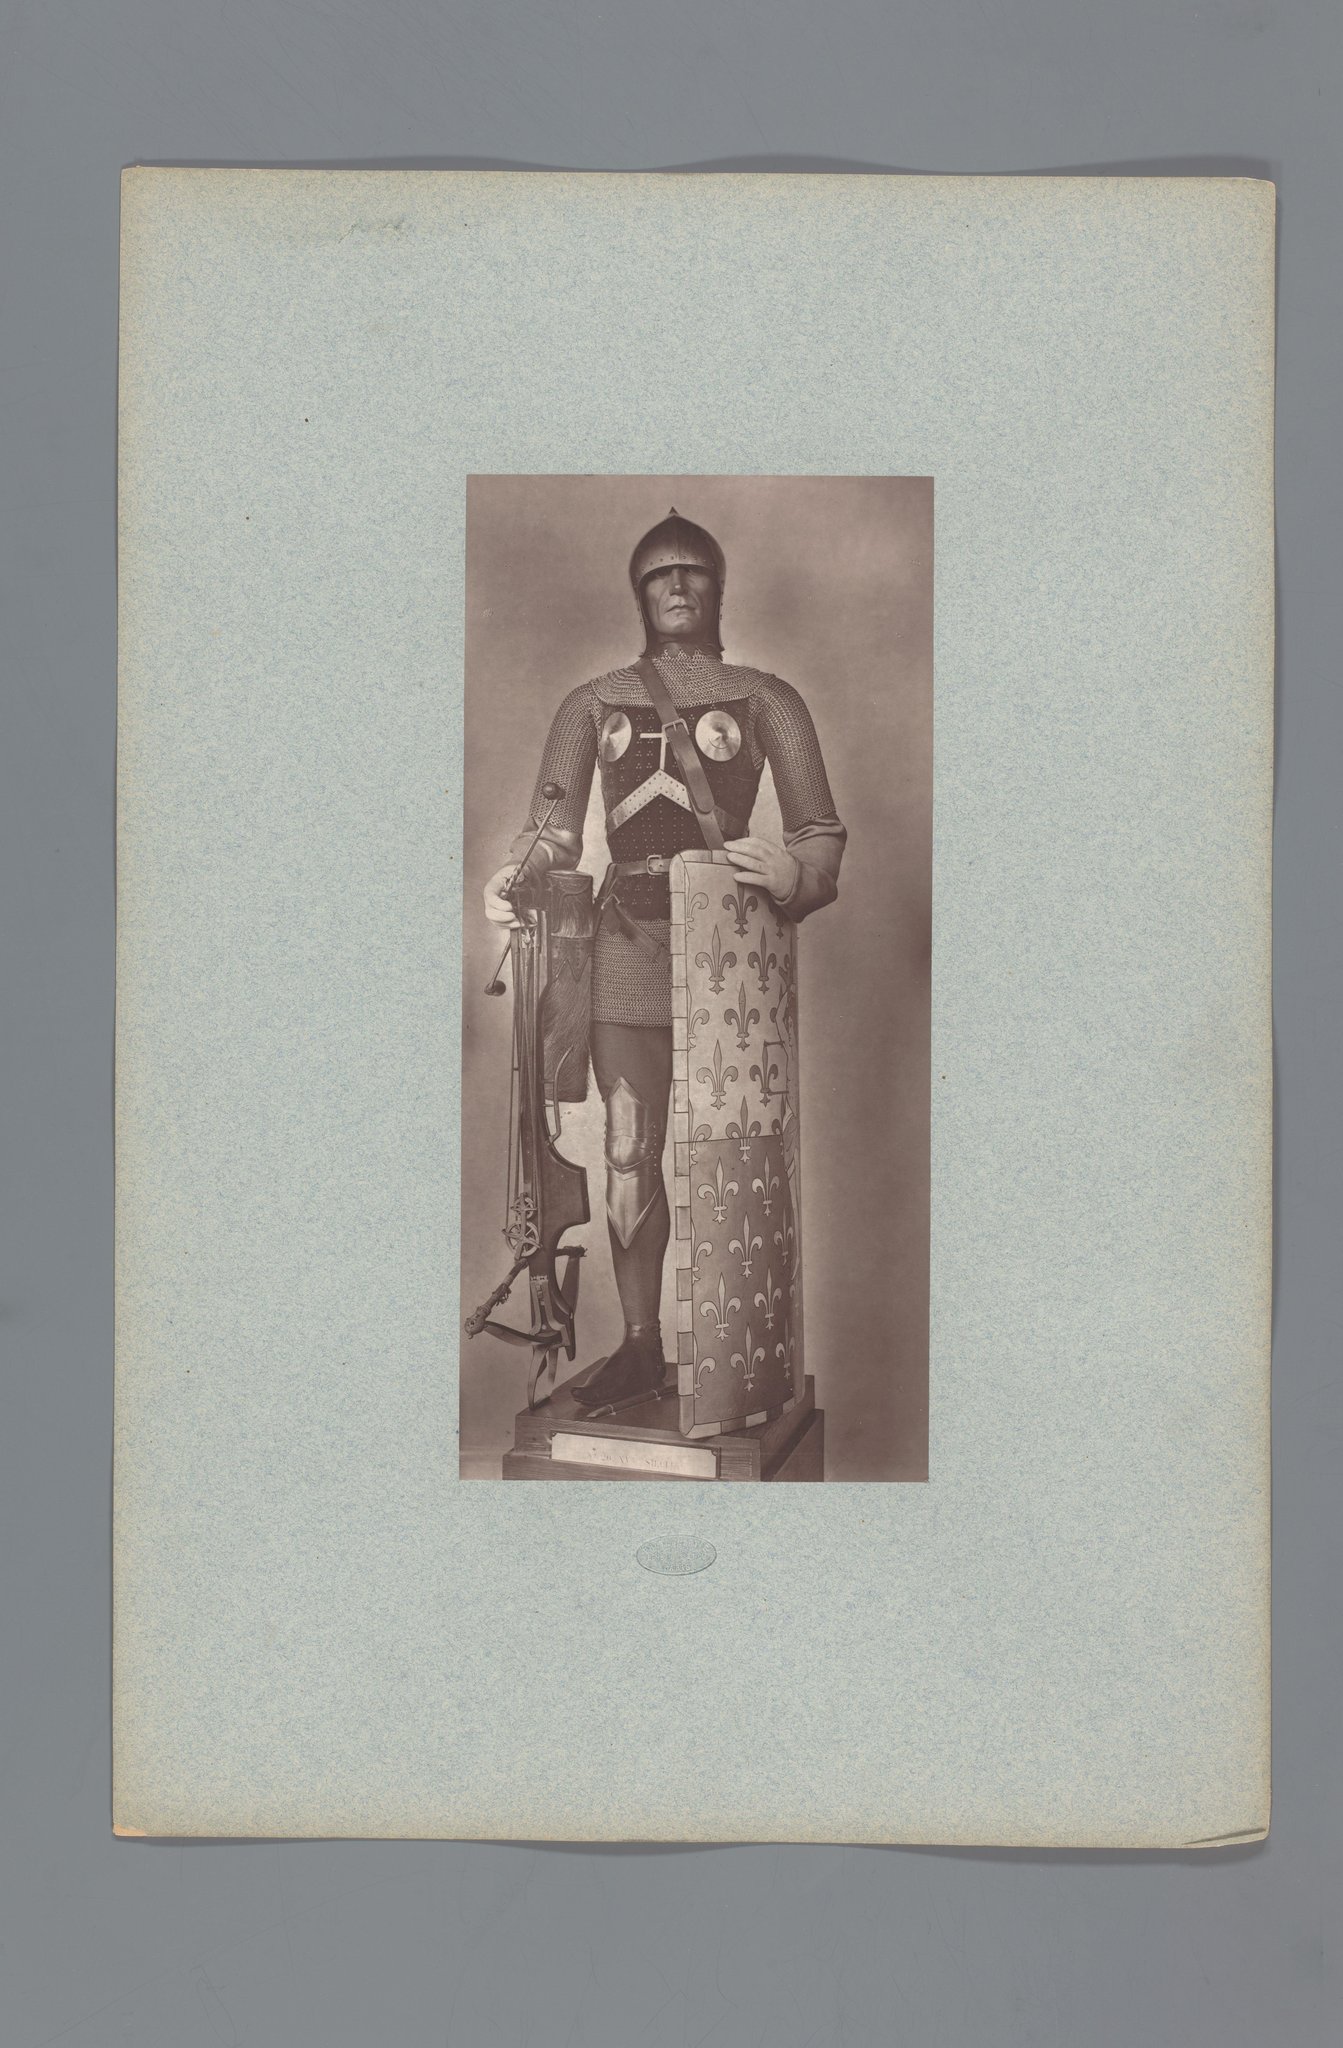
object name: photomechanical print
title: 15de-eeuws harnas met kruisboog en schild uit het leger van Karel VII van Frankrijk, uit de collectie van het Musée d'Artillerie in Parijs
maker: Anonymous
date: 1877-1882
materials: paper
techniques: woodburytype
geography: paris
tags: protective weapons: shield, armour, archer's weapons: crossbow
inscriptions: check stamp: ‘PHOTOGLYPTIE/ LEMERCIER ET Cie/ PARIS’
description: Deze prent maakt deel uit van een omslag met 36 prenten, een titelblad en een lijst van afbeeldingen.